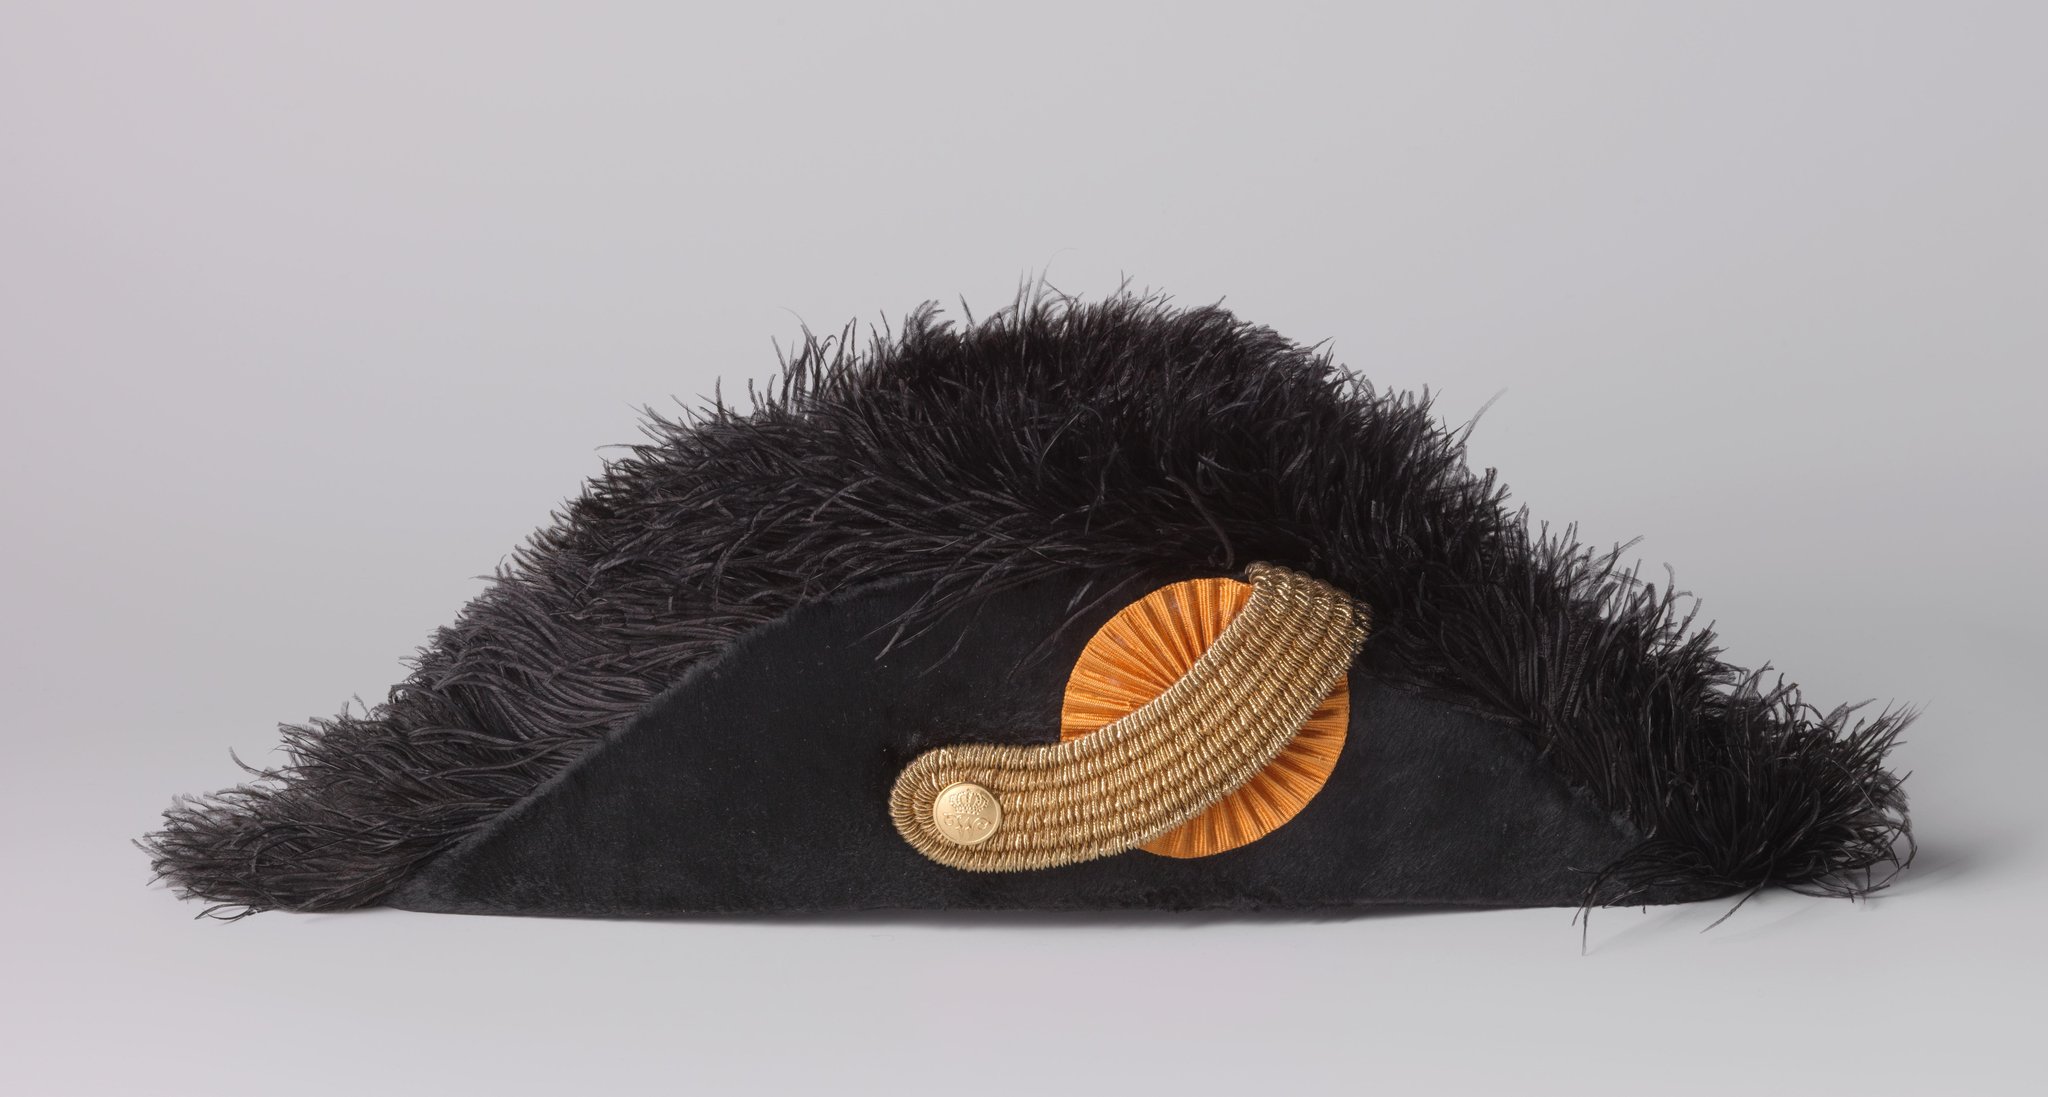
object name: bicorne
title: Steek behorend bij ambtskostuum van H.R. Rookmaker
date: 1933-1957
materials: textile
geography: surabaya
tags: dutch east indies, the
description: Steek behorend bij ambtskostuum van H.R. Rookmaker.